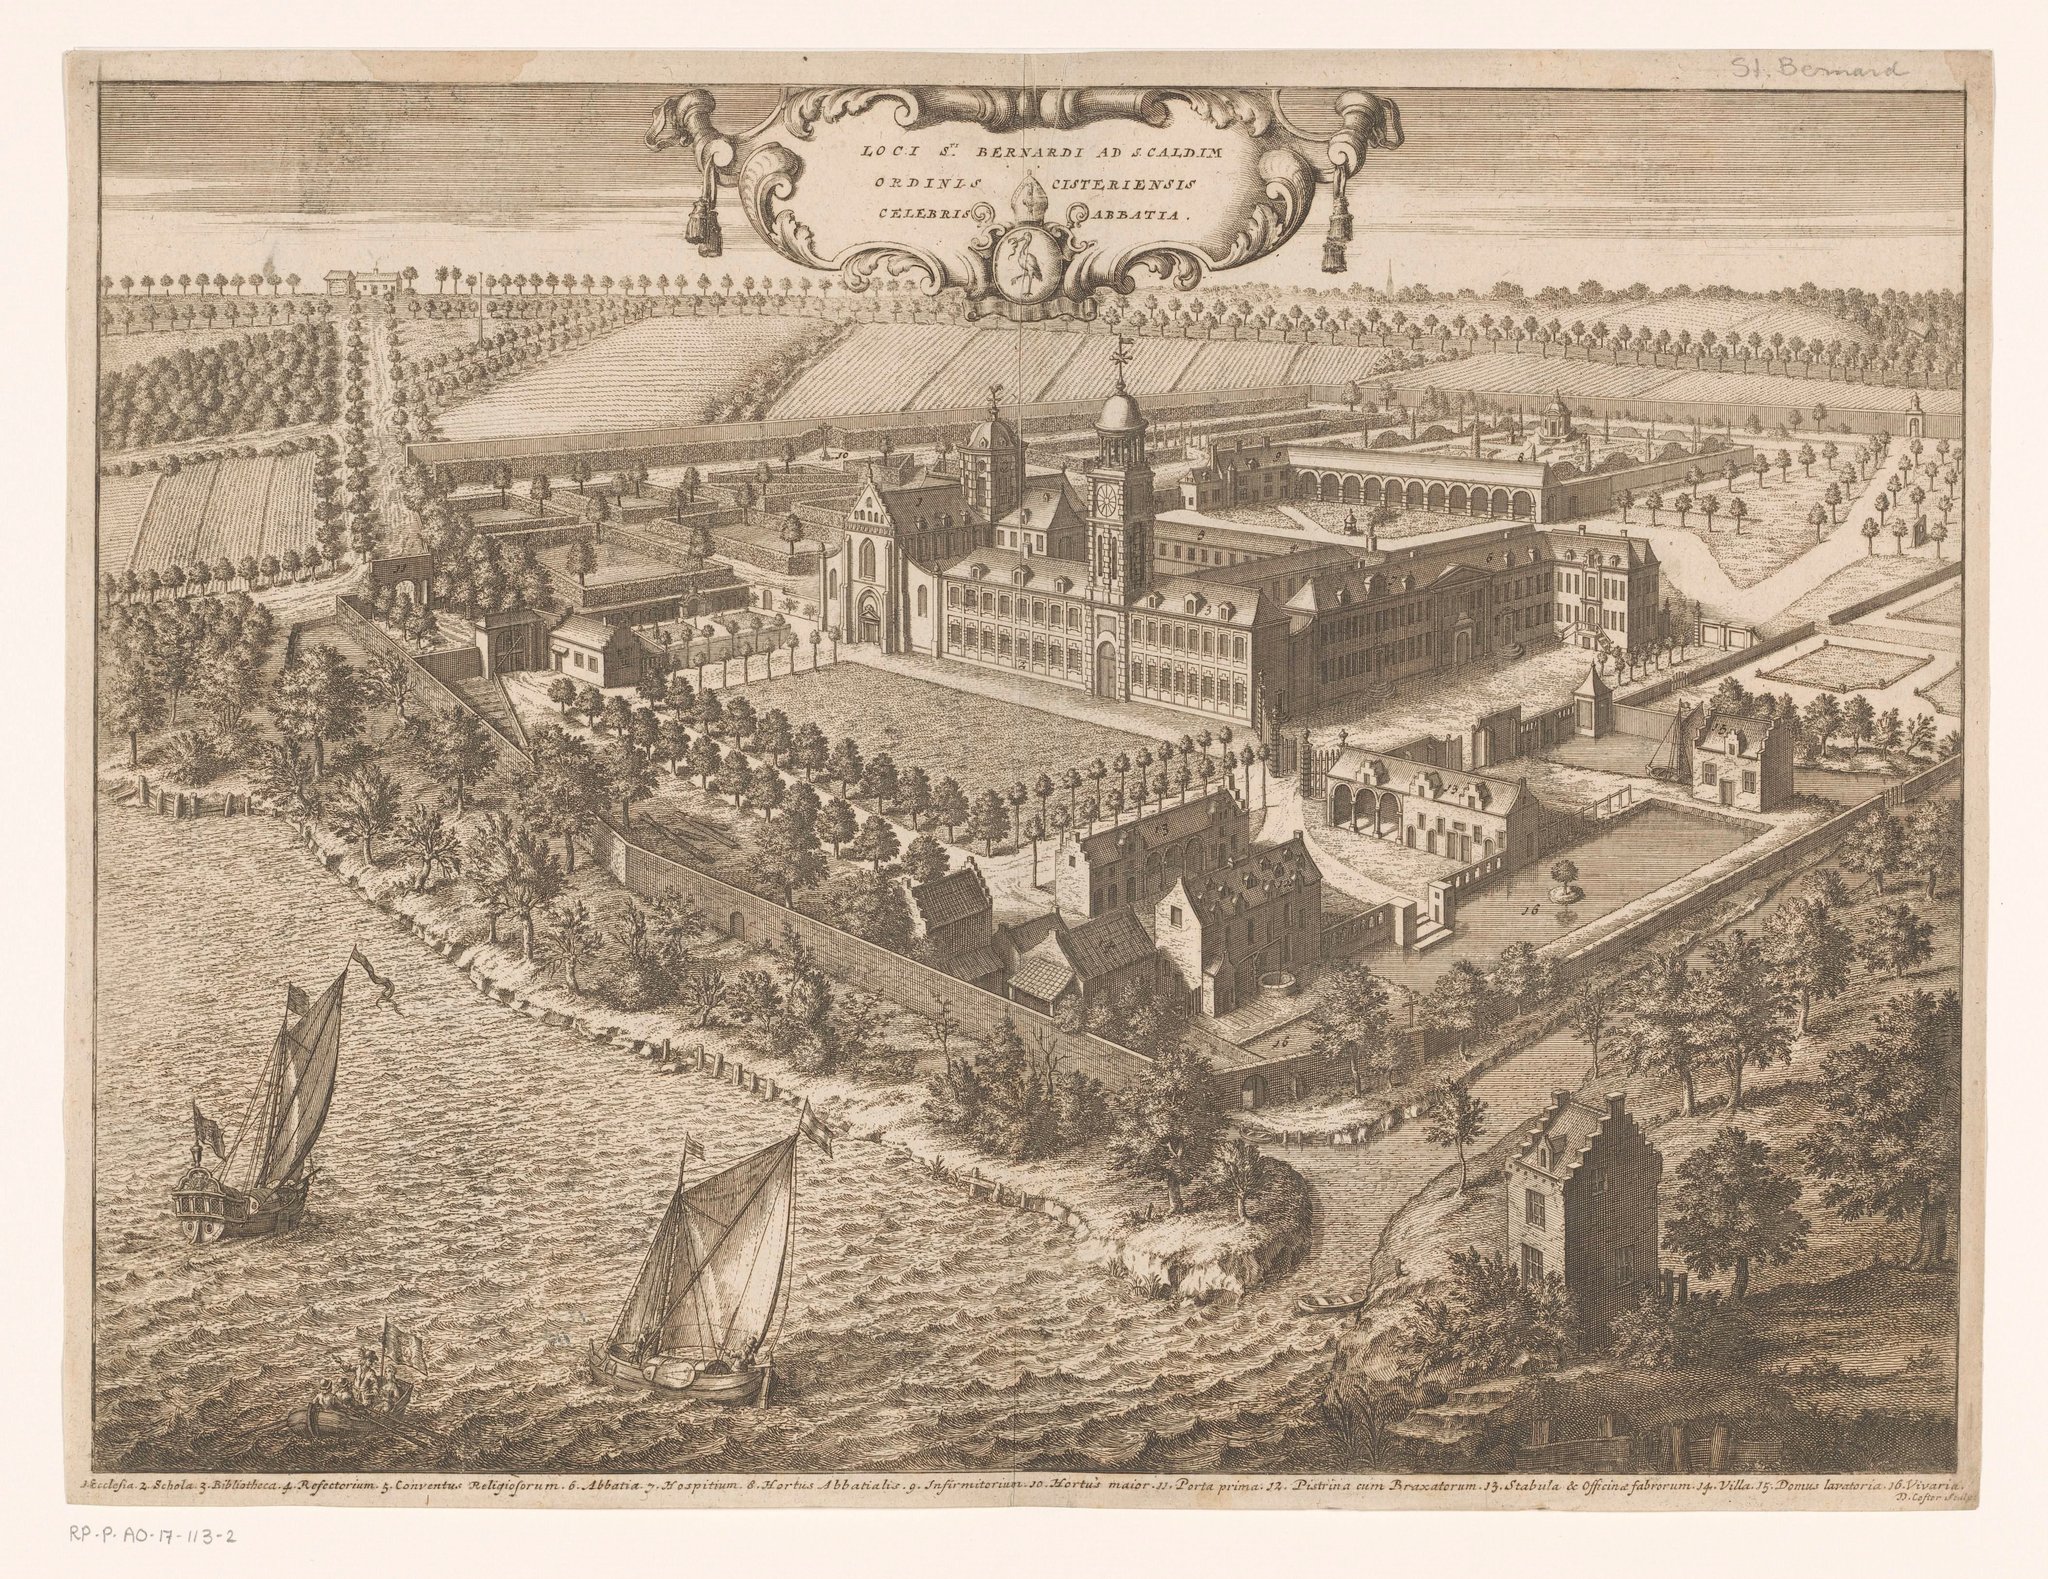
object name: book illustration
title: Gezicht op de Sint-Bernardusabdij, te Hemiksem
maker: david coster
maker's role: print maker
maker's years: 1676-1752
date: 1726-1734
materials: paper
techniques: engraving, etching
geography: the hague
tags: coat of arms (as symbol of the state, etc.) (+ city; municipal), sailing-ship, sailing-boat, abbey, monastery, convent ~ roman catholic church, church (exterior), rowing-boat, canoe, etc.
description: Prent ook gebruikt in: Sanderus, Antonius. Groot kerkelyk toneel des Hertogdoms van Brabant (...). Den Haag: Christiaan van Lom, 1727. En in: Sanderus, Antonius. Antonii Sanderi presbyteri Chorographia sacra Brabantiæ. 3 delen. Den Haag: Christiaan van Lom, 1726-1727, dl. 1 (1726). En in: Sanderus, Antonius. Le grand theatre sacré du duché de Brabant (...). 4 delen. Den Haag: Gerard Block, 1729-1734.